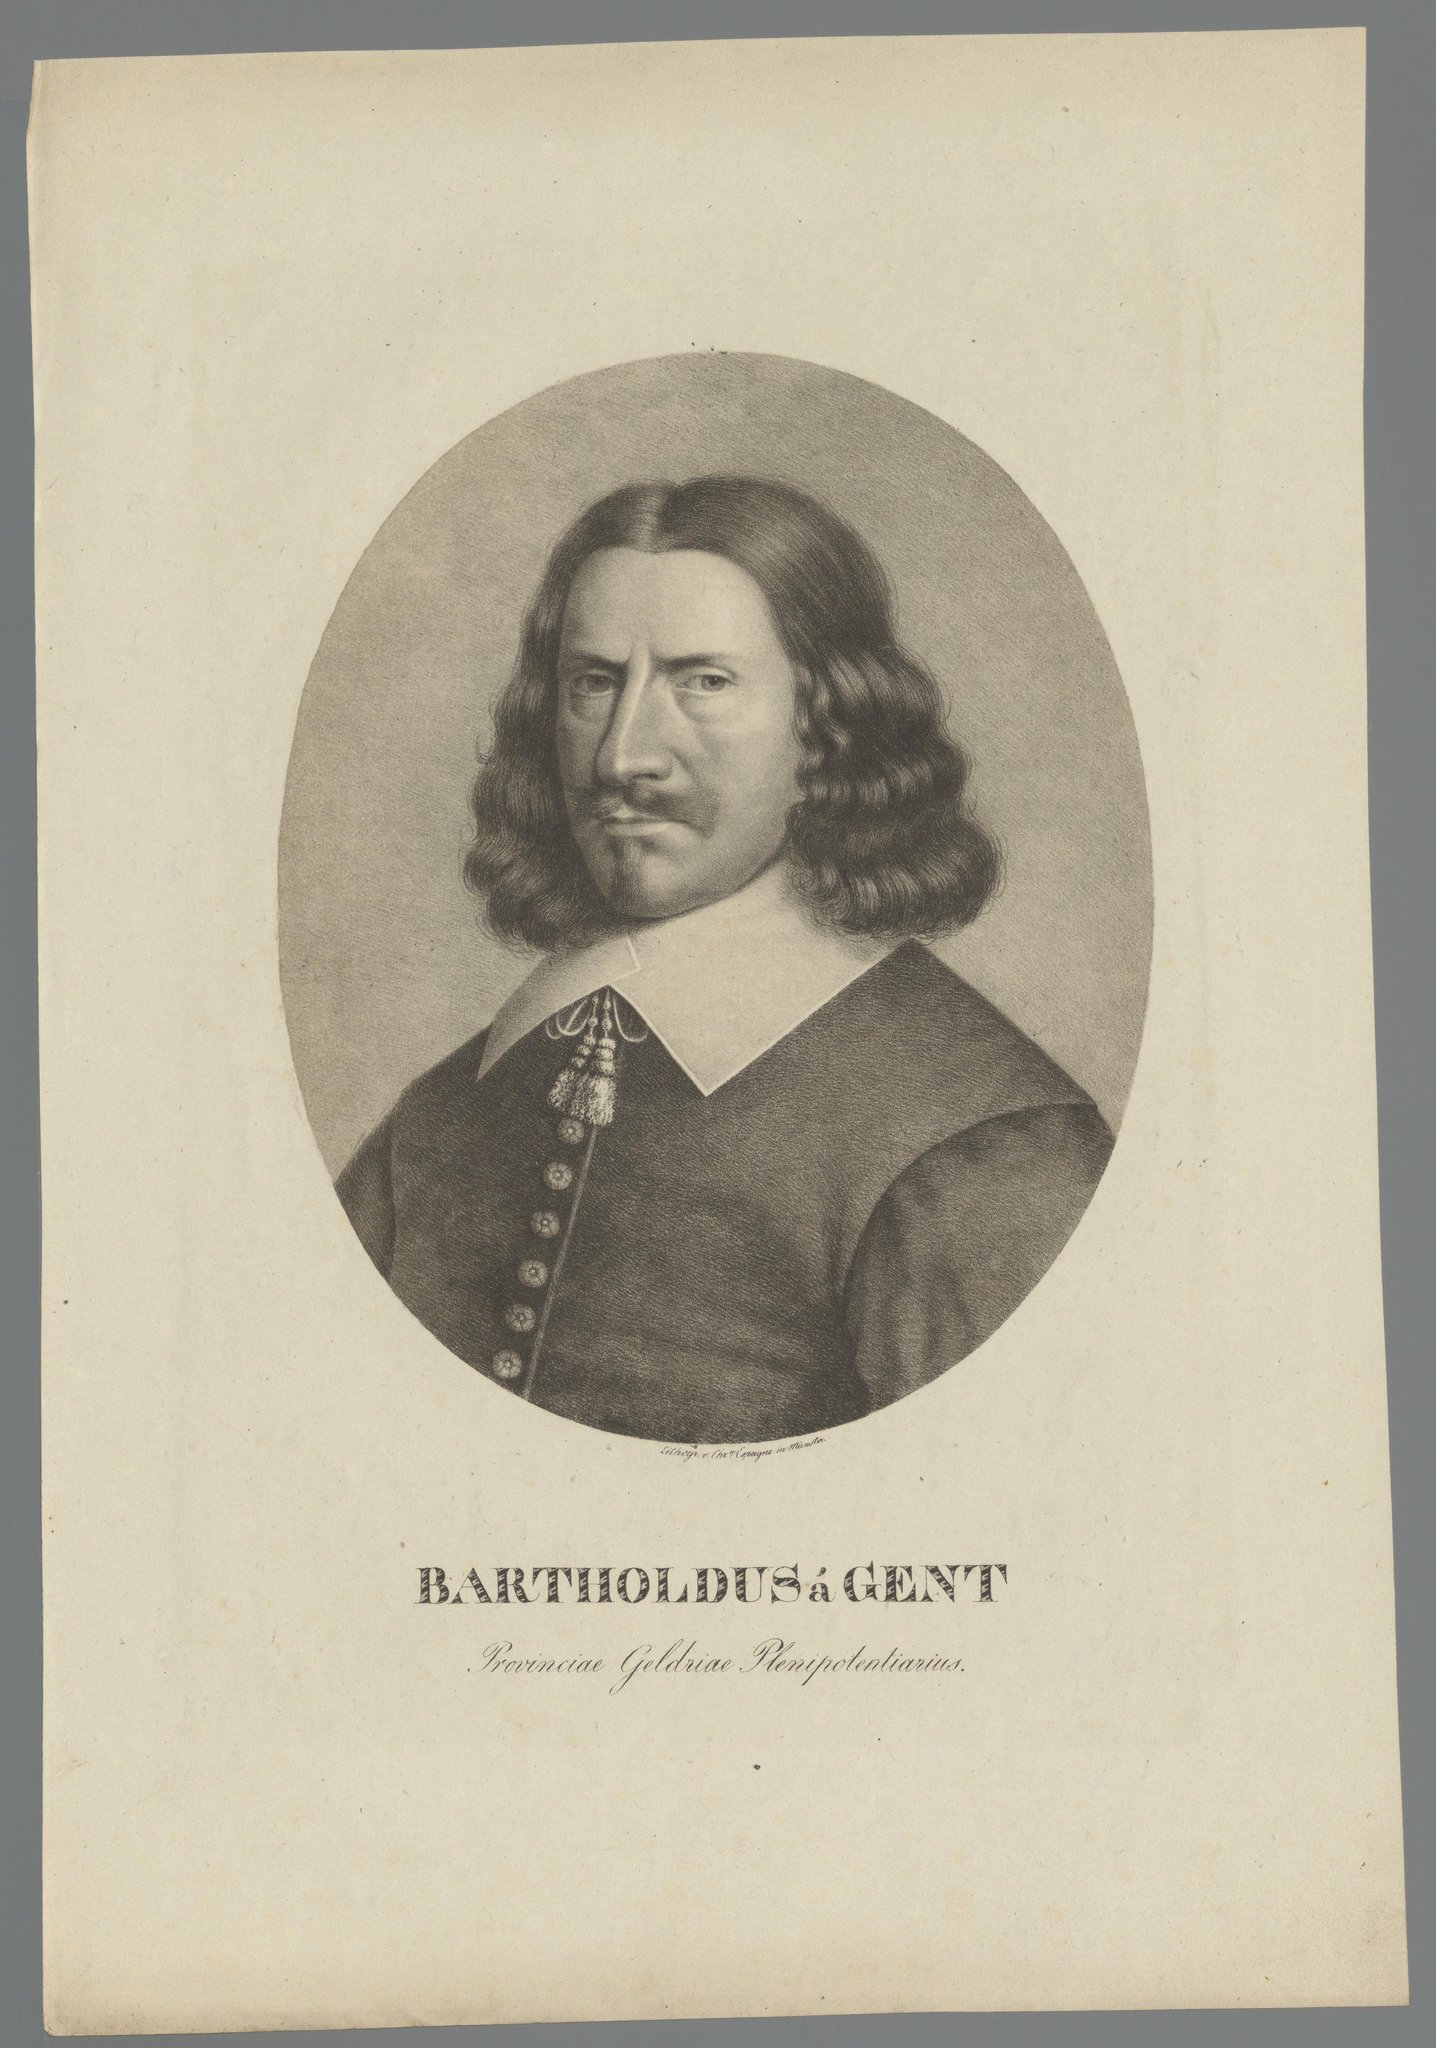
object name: print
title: Bartholdus à Gent, provinciae Geldriae plenipotentiarius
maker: christian espagne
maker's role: print maker, printer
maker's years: 1794-1838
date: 1824-1827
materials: paper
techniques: tone lithography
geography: munster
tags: adult man, historical persons, beard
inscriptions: collector's mark: Lugt 2228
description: Prent uit: Bildnisse der beim westfälischen Friedensschluß zu Münster und Osnabrück versammelt gewesenen Gesandten. Münster: Christian Espagne, [1824-1827]. Deze publicatie bevat een onbekend aantal lithografieën, die in afleveringen verschenen als illustratie bij de tekst.